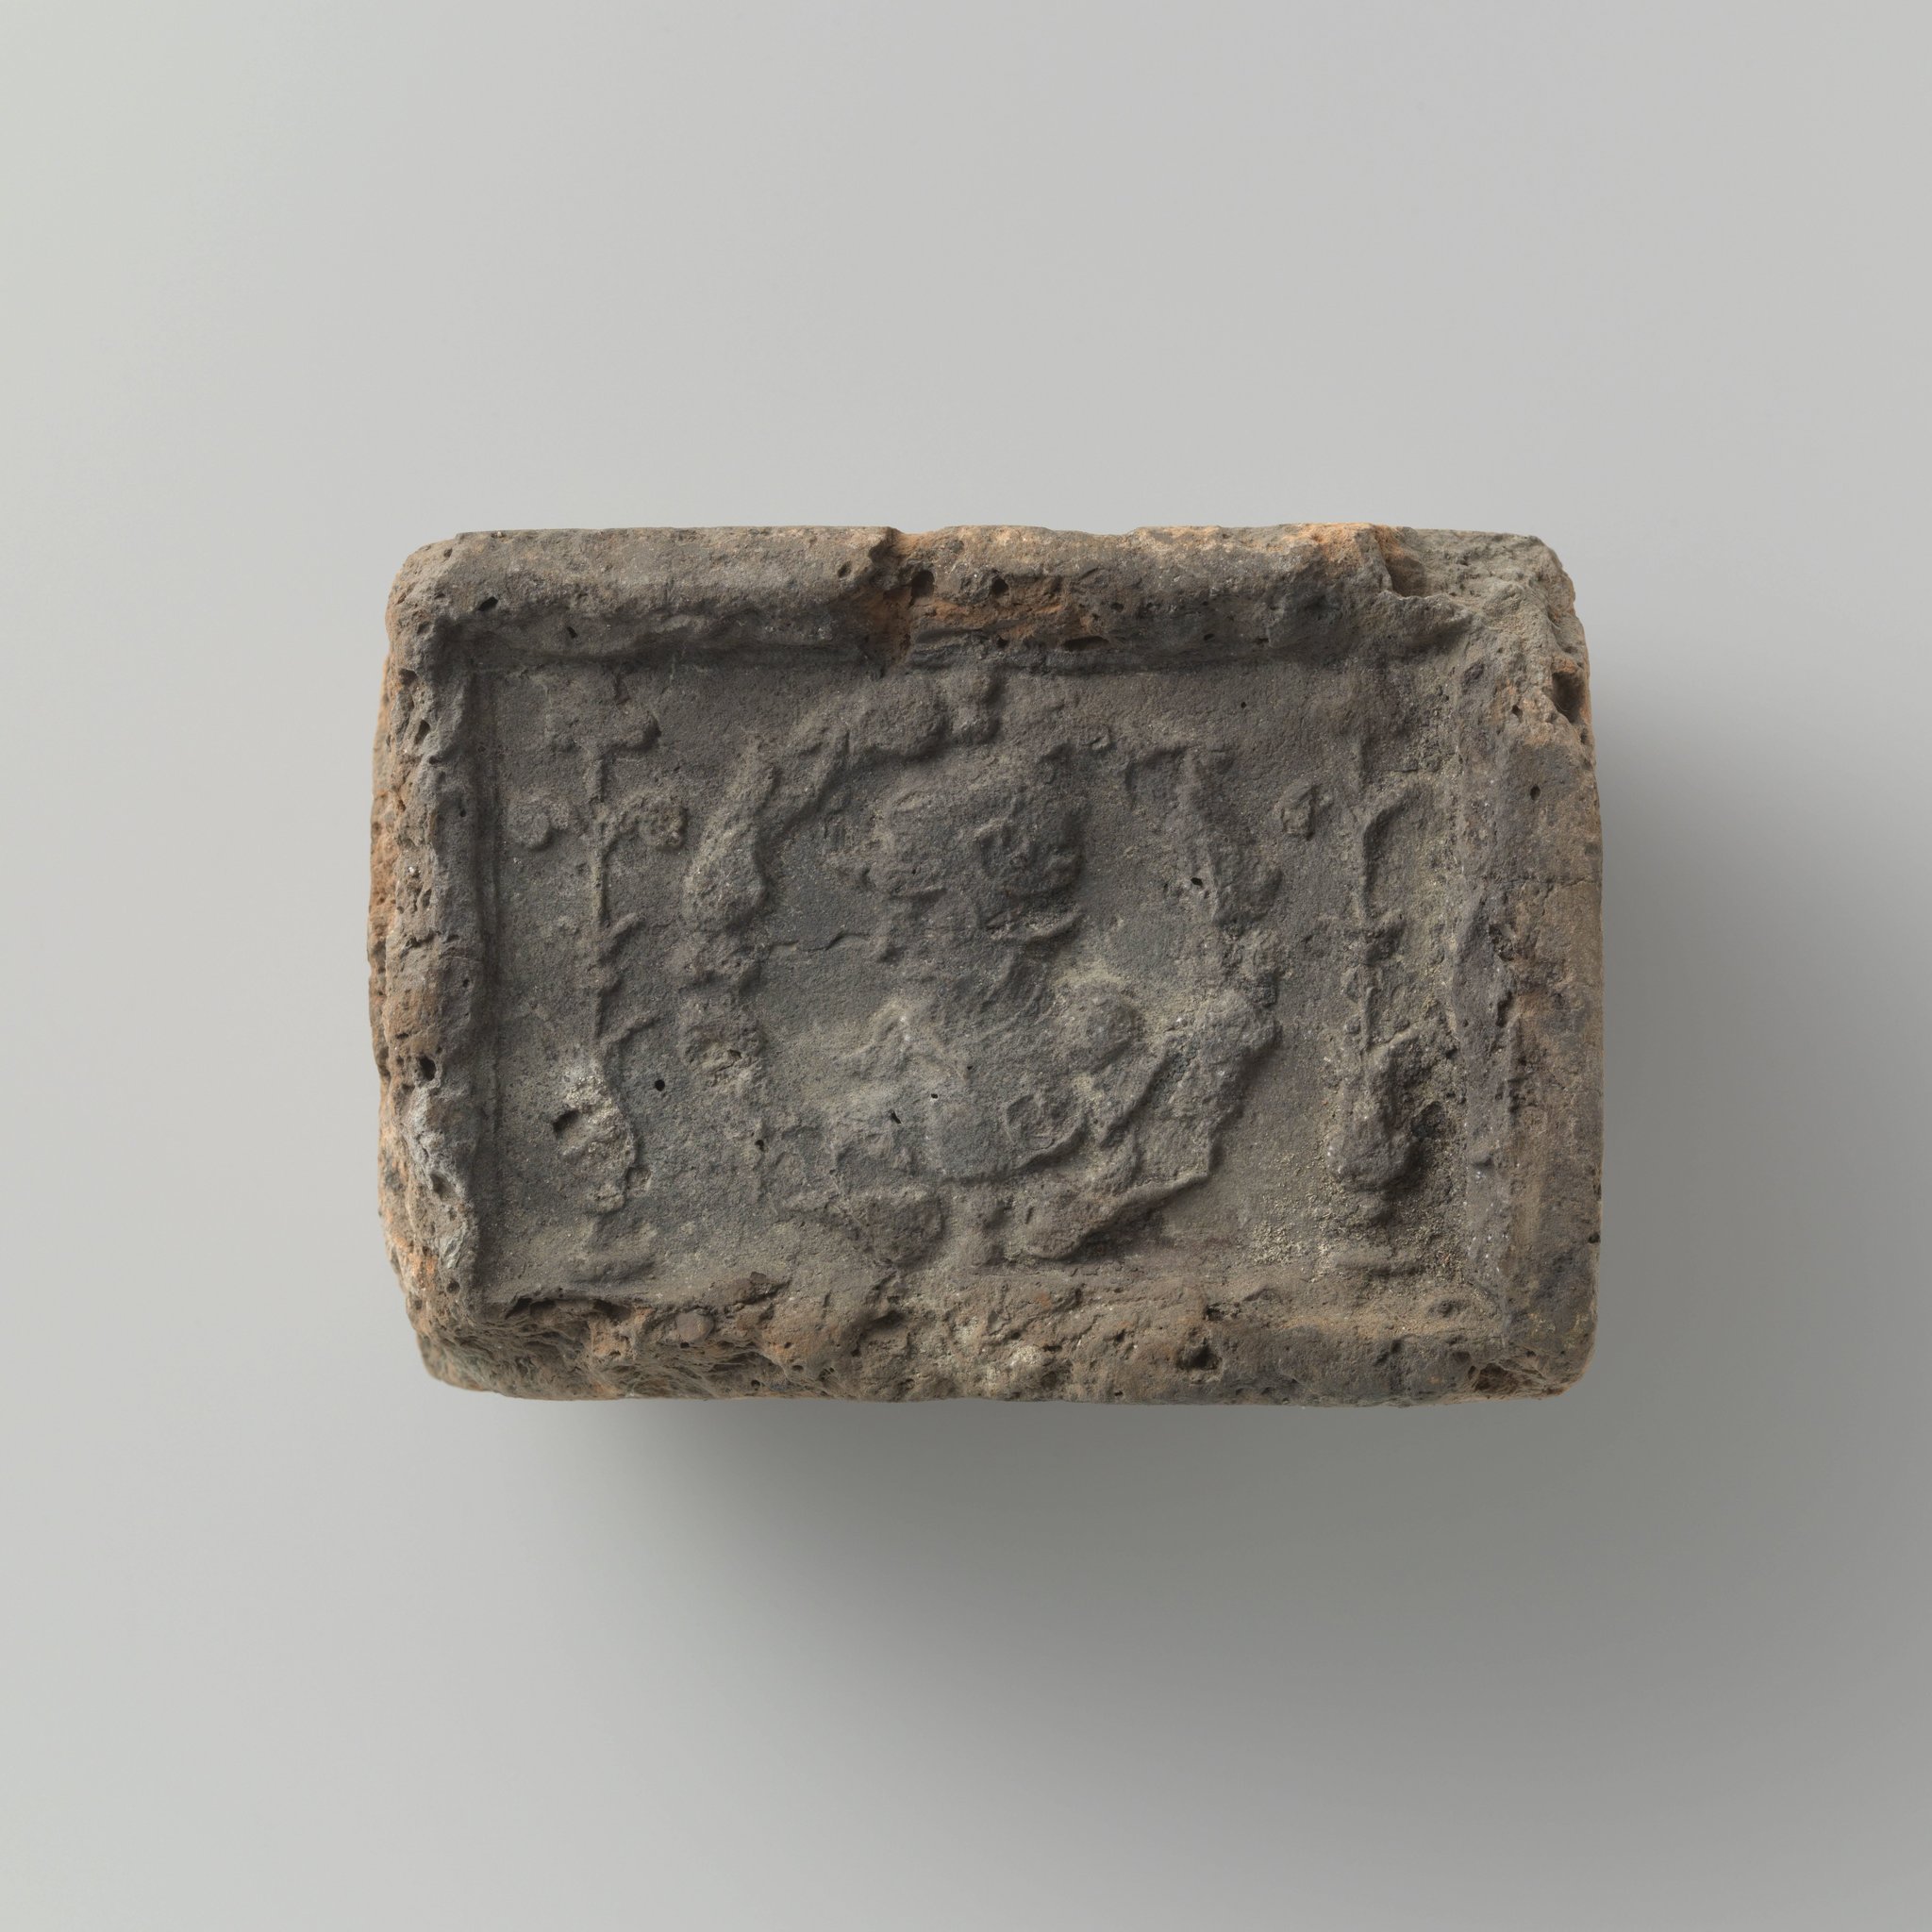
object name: hearthstone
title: Haardsteen met afbeelding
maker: Anonymous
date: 1580-1600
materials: earthenware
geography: southern netherlands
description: Een haardsteen met een medaillon, met een borstbeeld van een helm dragende Romein.